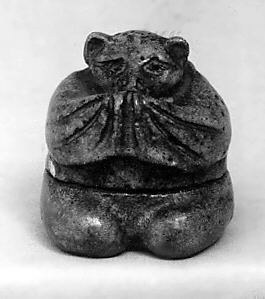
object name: incense box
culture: japanese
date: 1701-1800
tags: animals